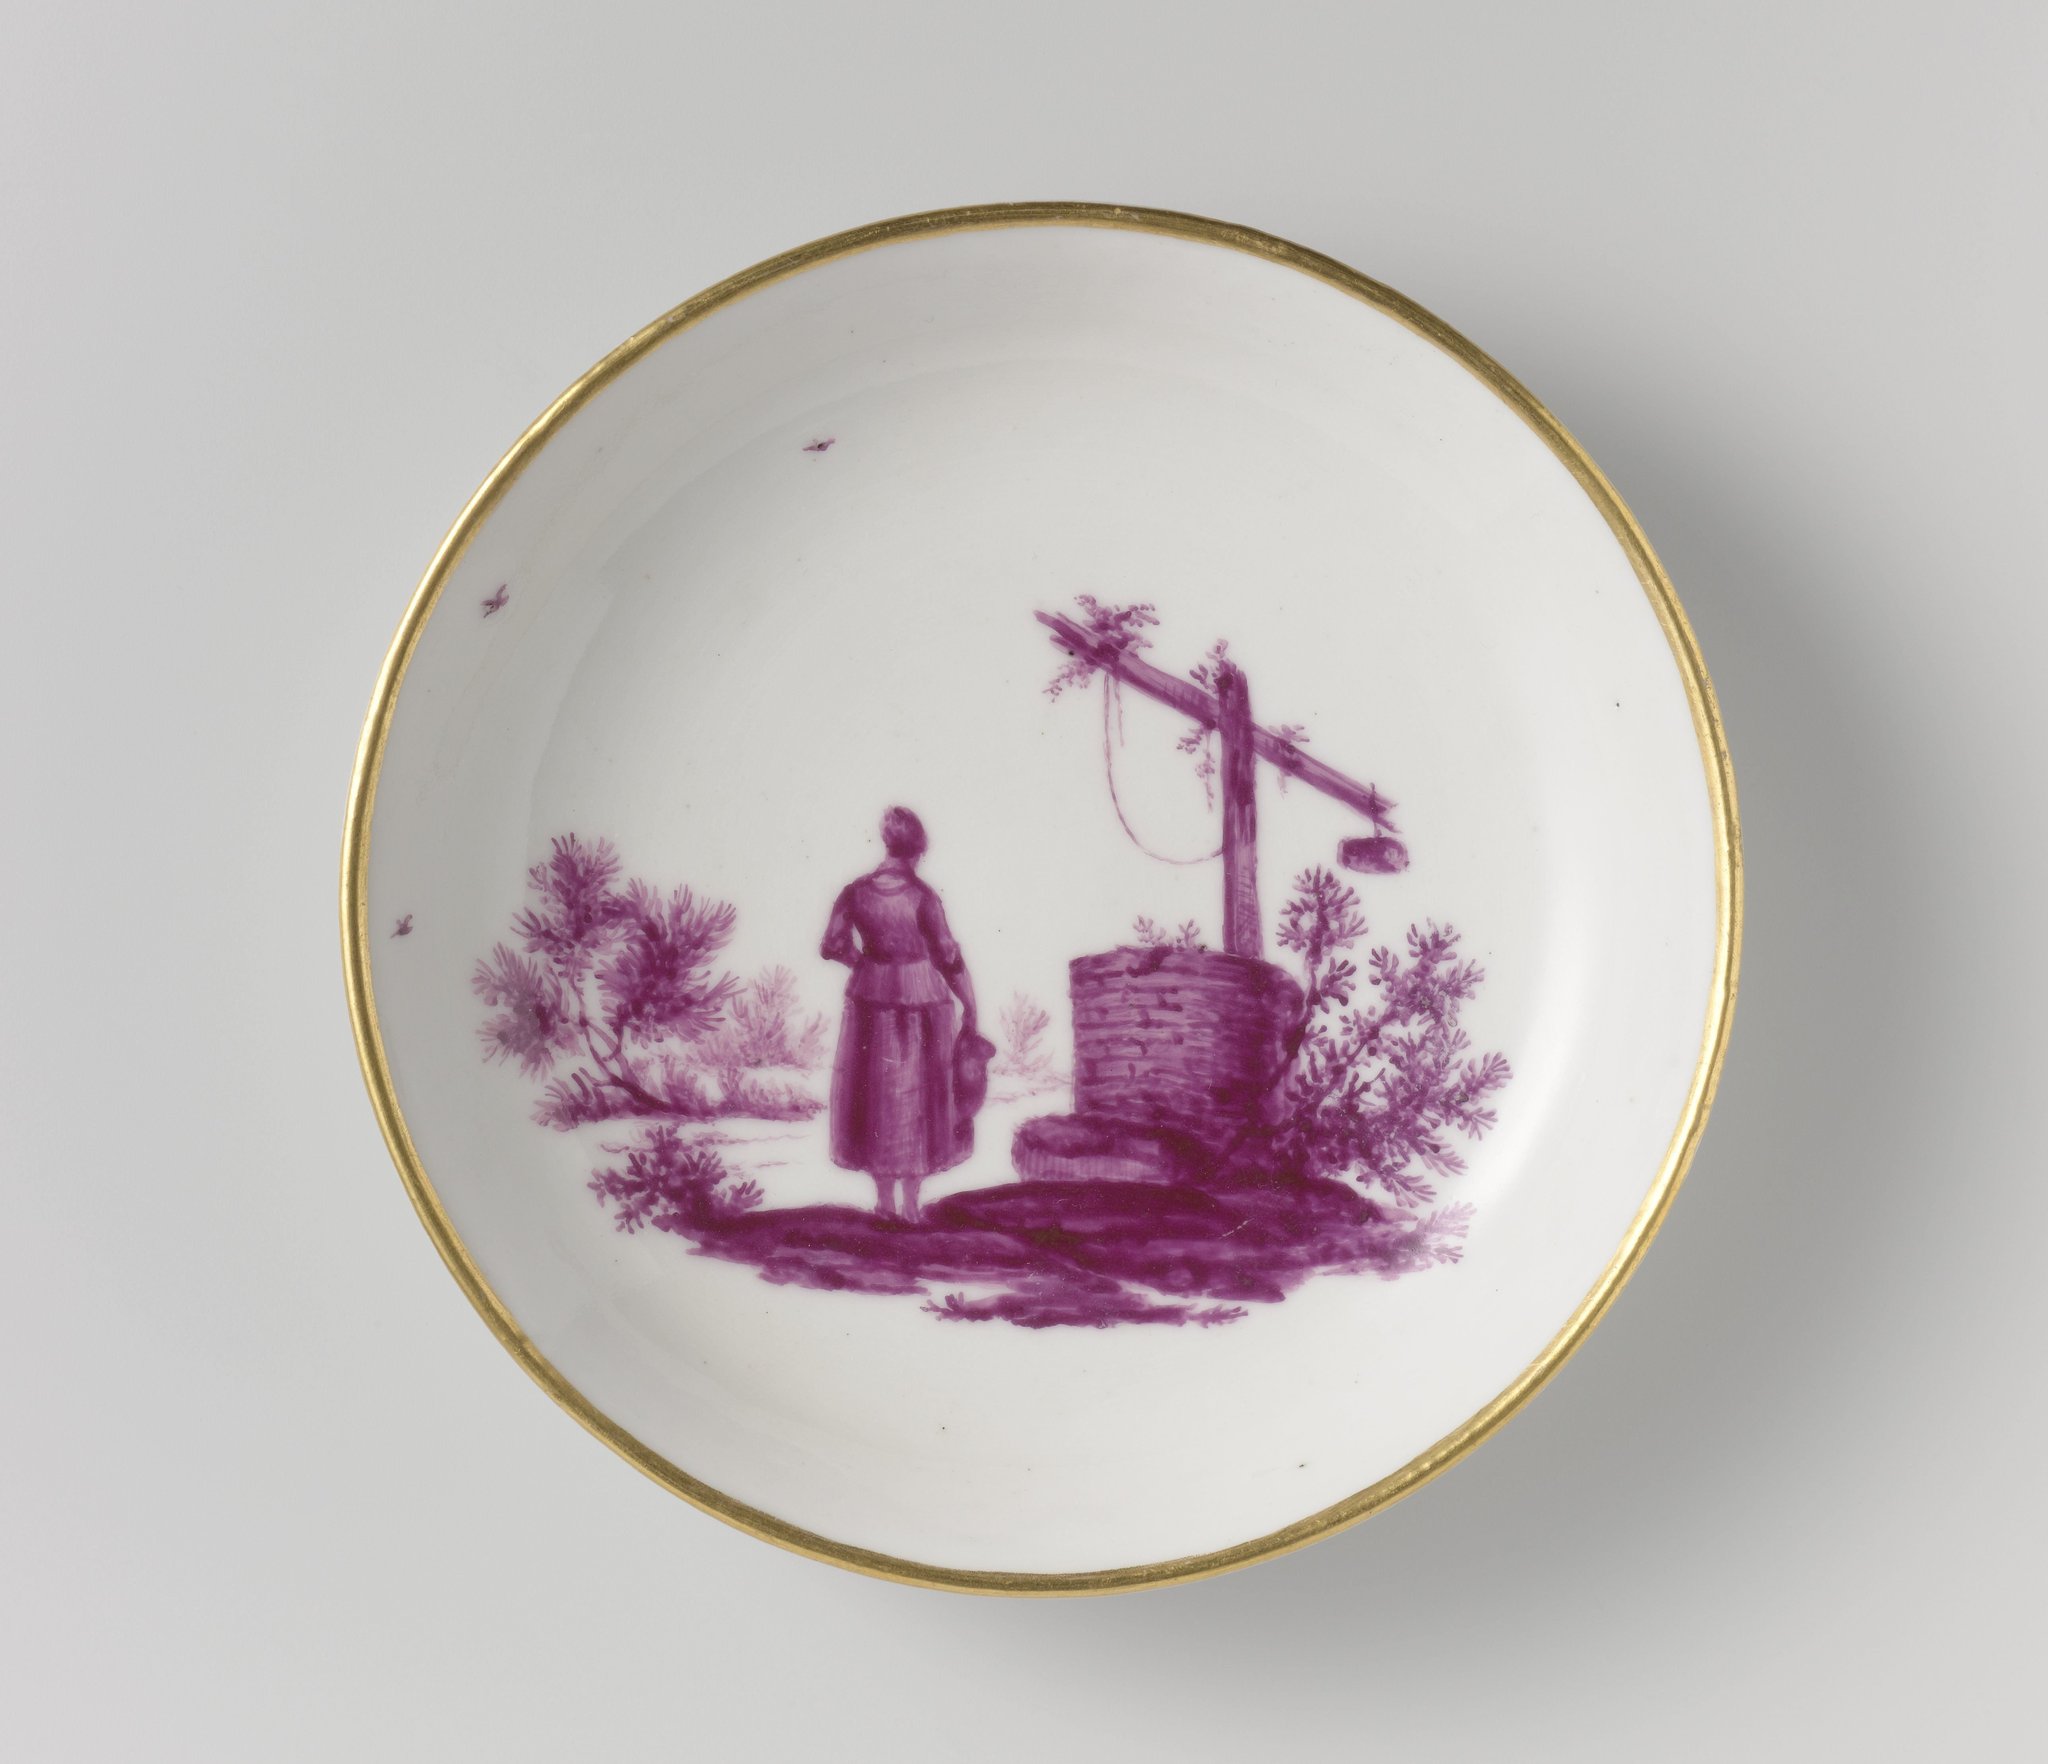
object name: platter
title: Schotel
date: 1775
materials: porcelain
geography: loosdrecht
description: Schotel van porselein. Onderdeel van een serie van twaafl stuks. Beschilderd met figuren in een landschap in bietenrood en gouden biezen.